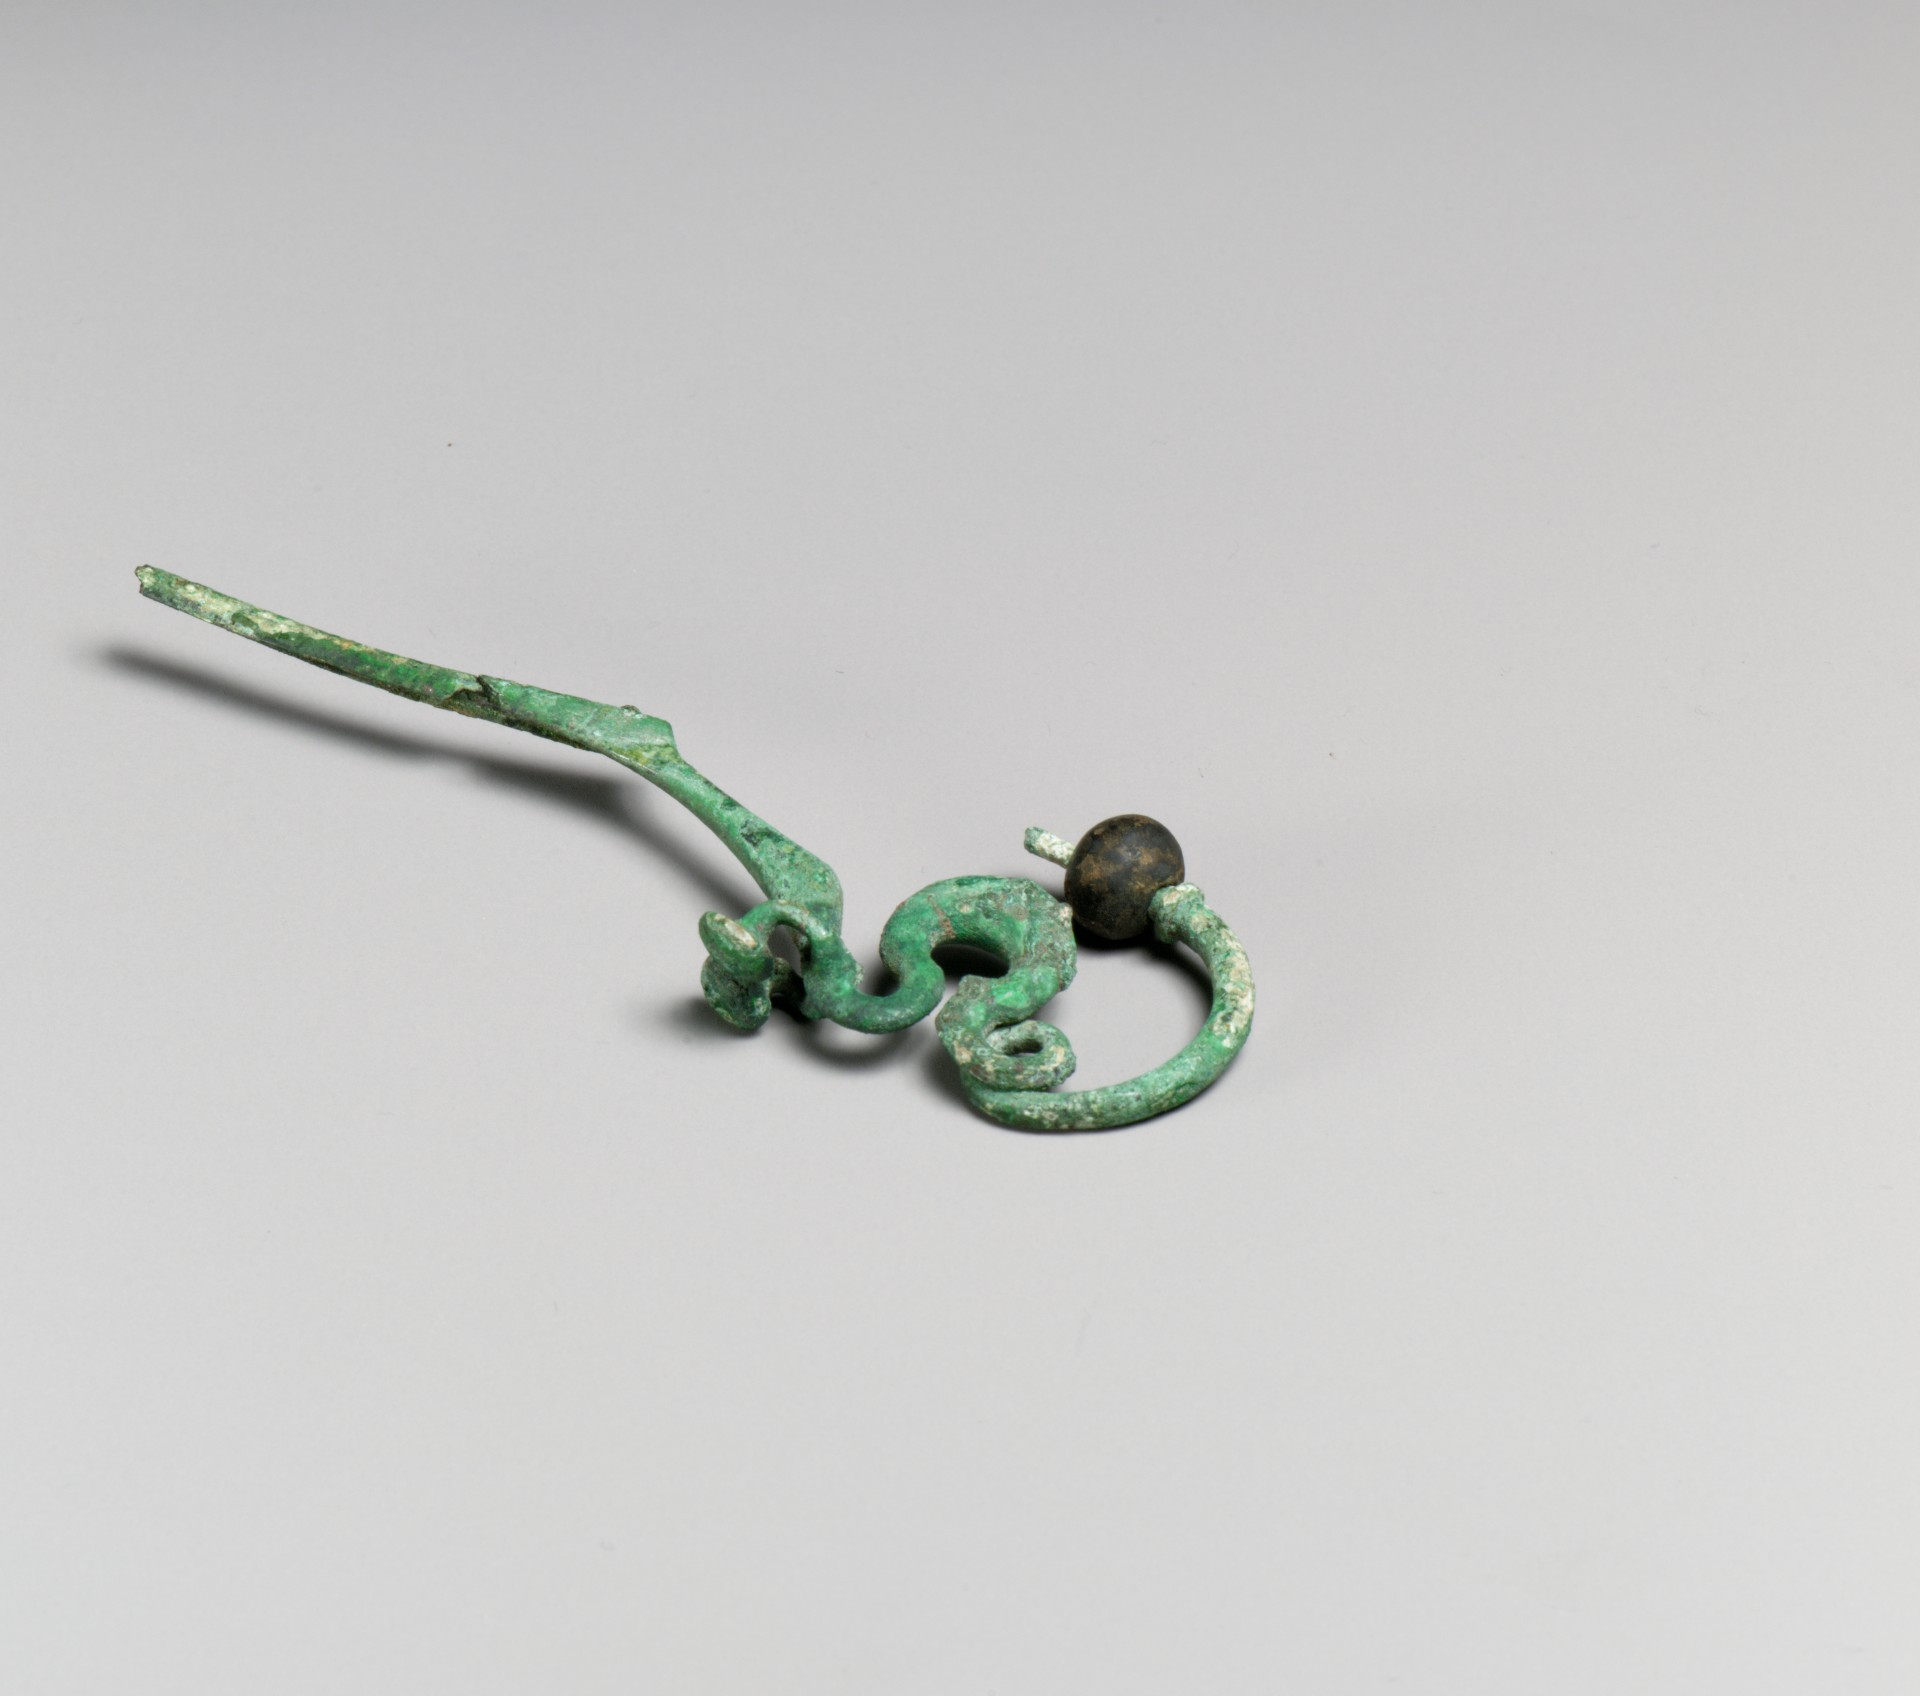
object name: fibula, serpentine type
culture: etruscan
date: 700-601 BCE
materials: bronze